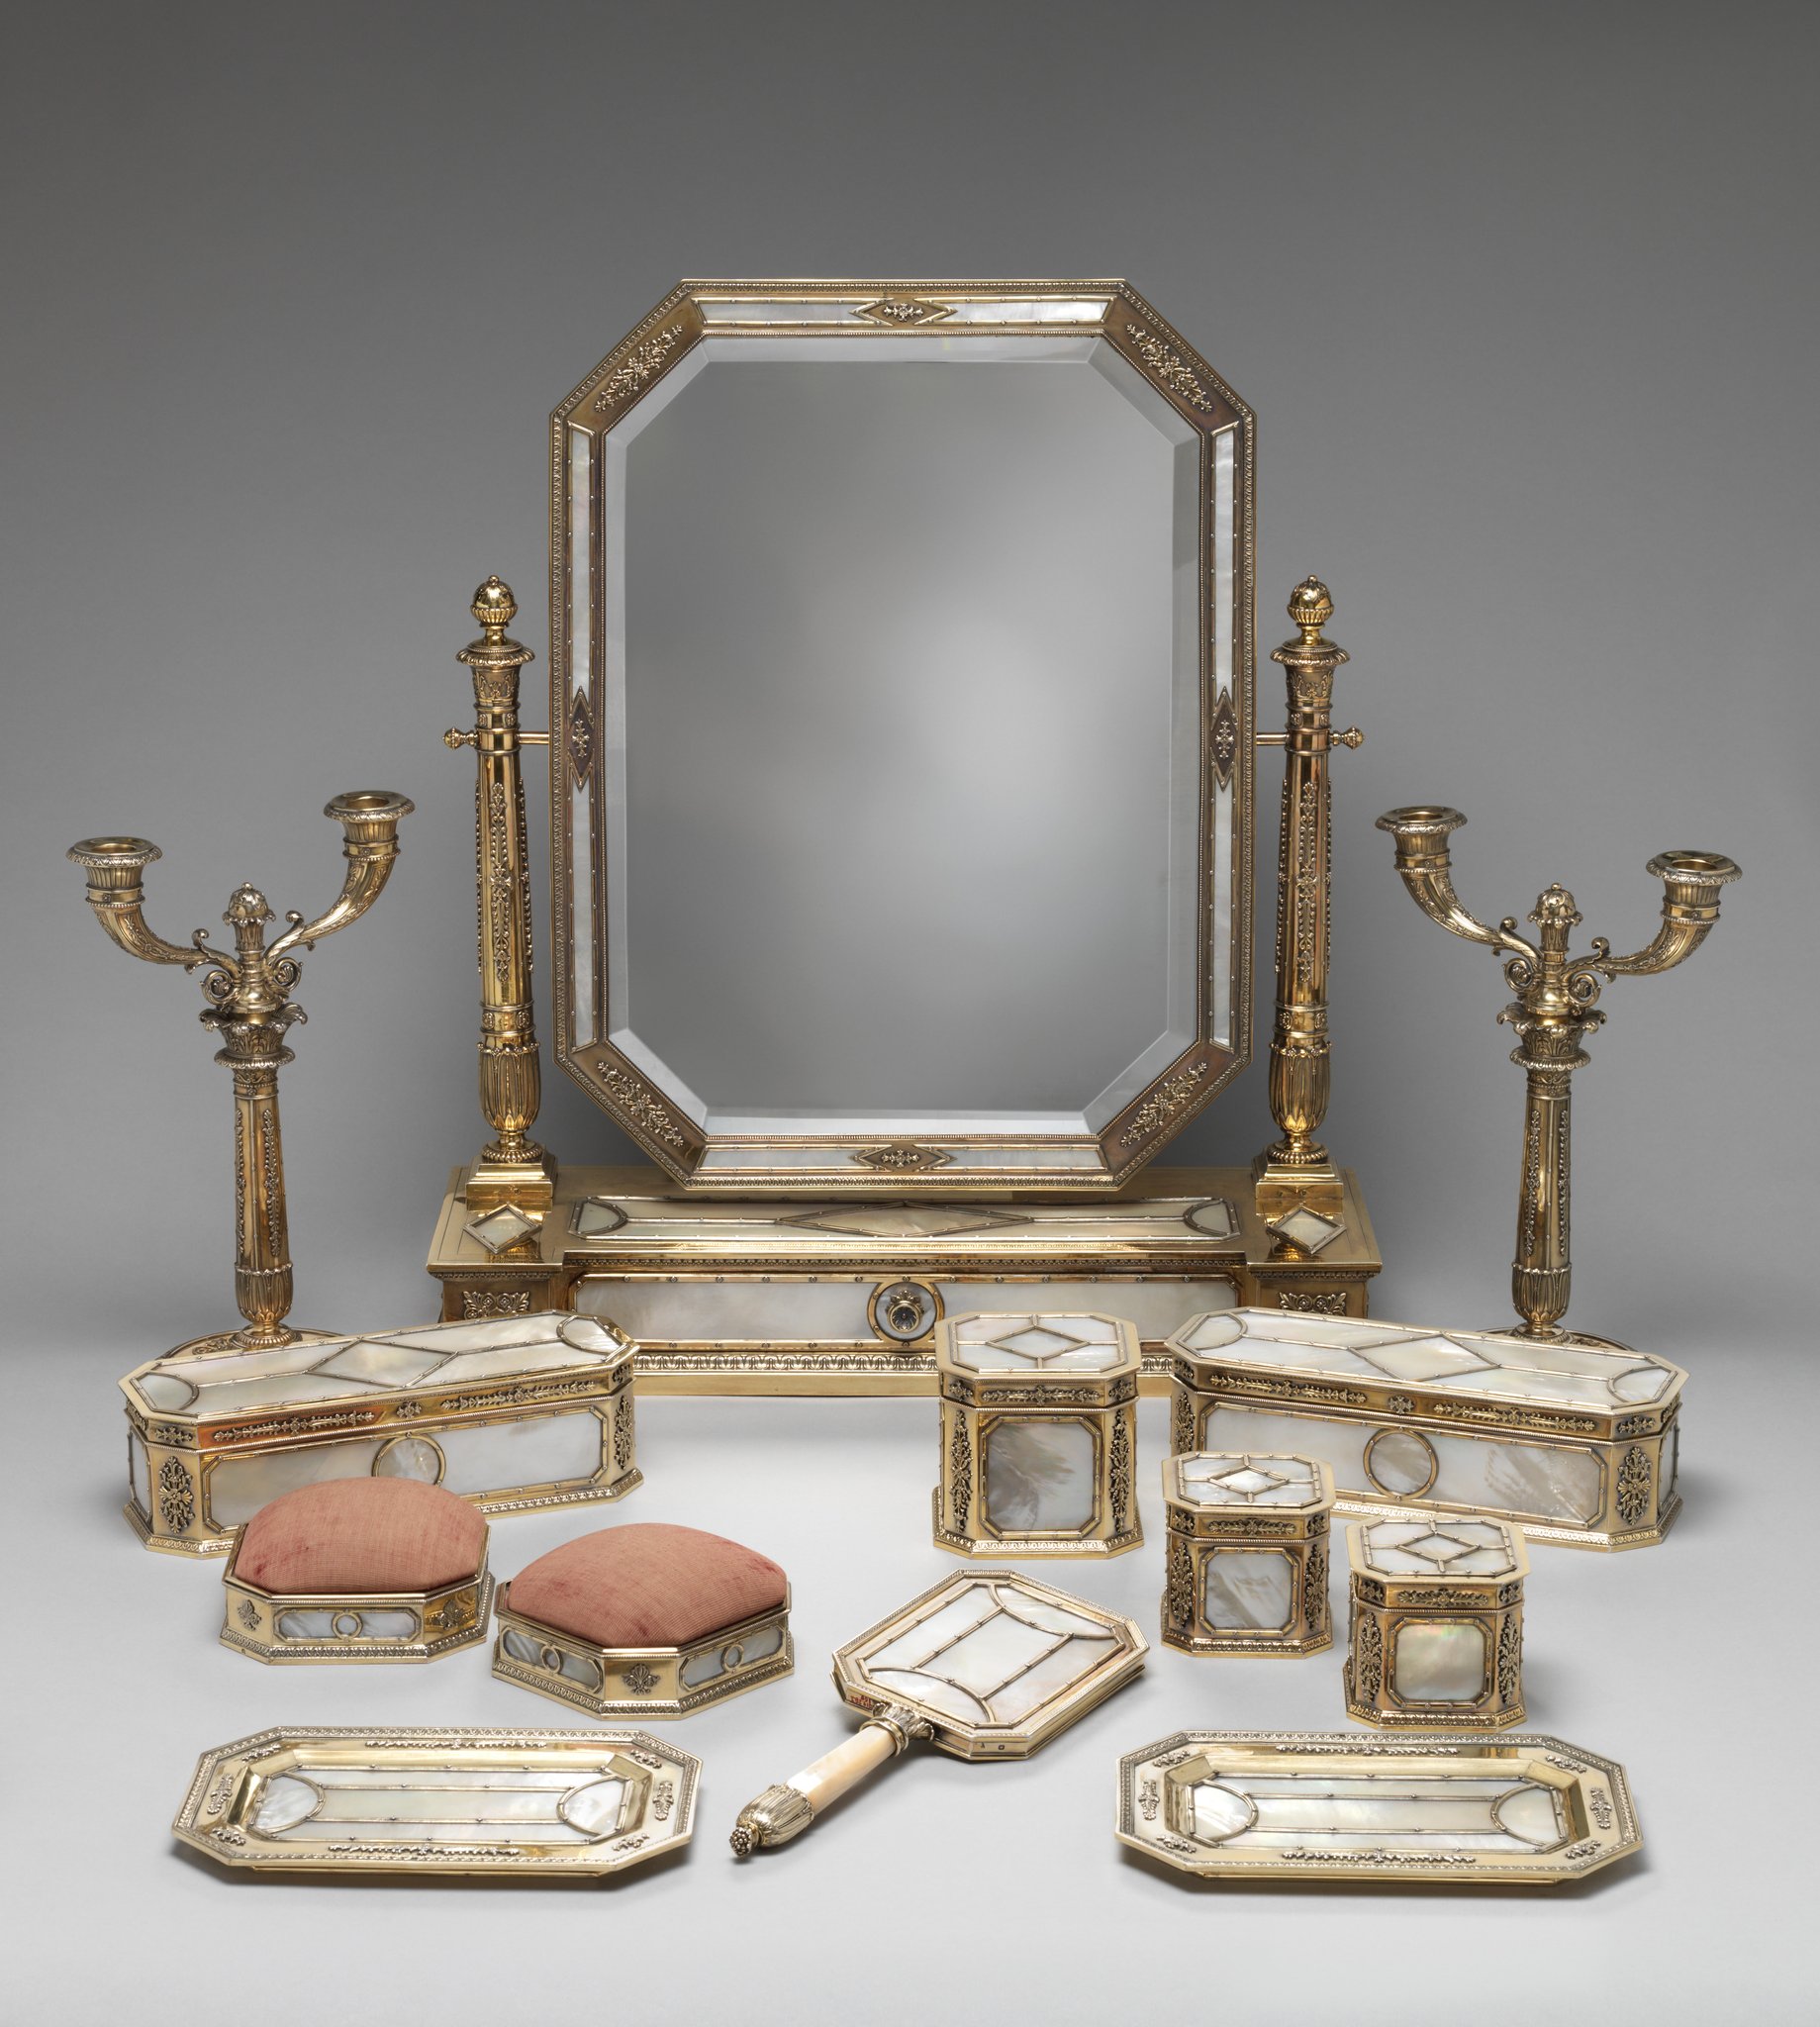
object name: dressing table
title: Dressing table set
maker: andré aucoc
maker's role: maker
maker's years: 1825-1925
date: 1887-1911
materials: mother of pearl, silver gilt, velvet